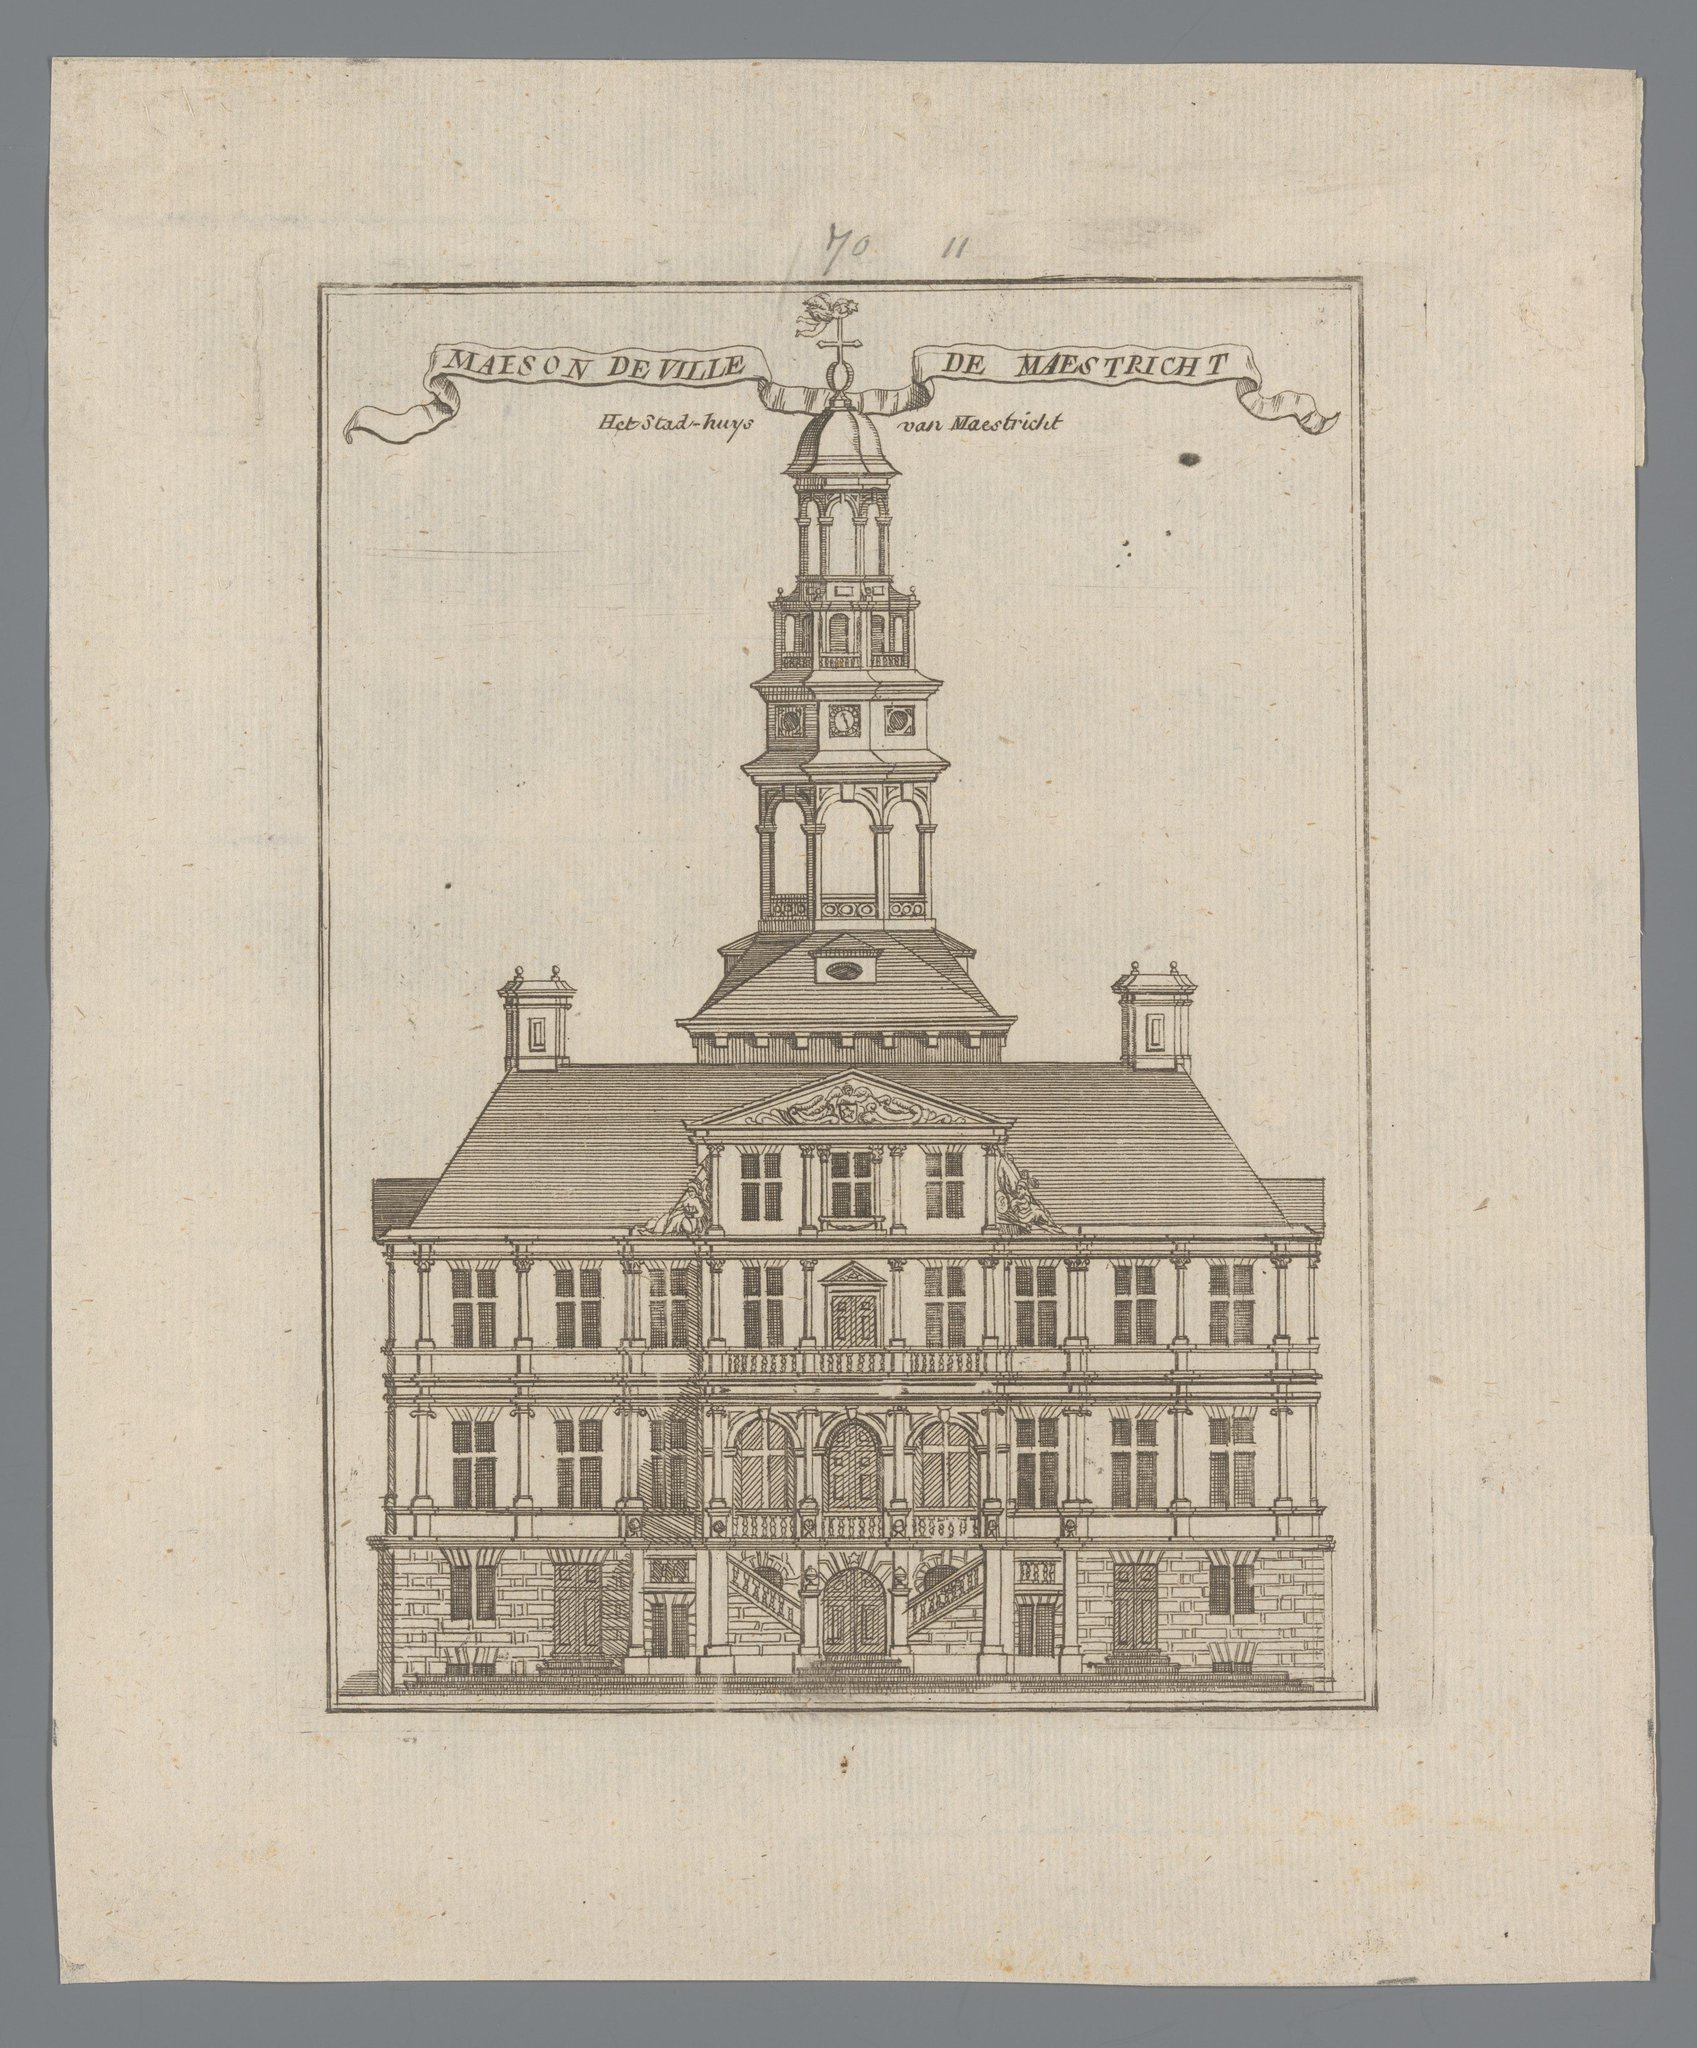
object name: print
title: Maeson de ville de Maestricht / Het Stad-huys van Maestricht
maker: jacobus harrewijn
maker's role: print maker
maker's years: 1660-1740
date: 1700-1750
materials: paper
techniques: etching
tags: townhall, exterior ~ architectural design or model, maastricht